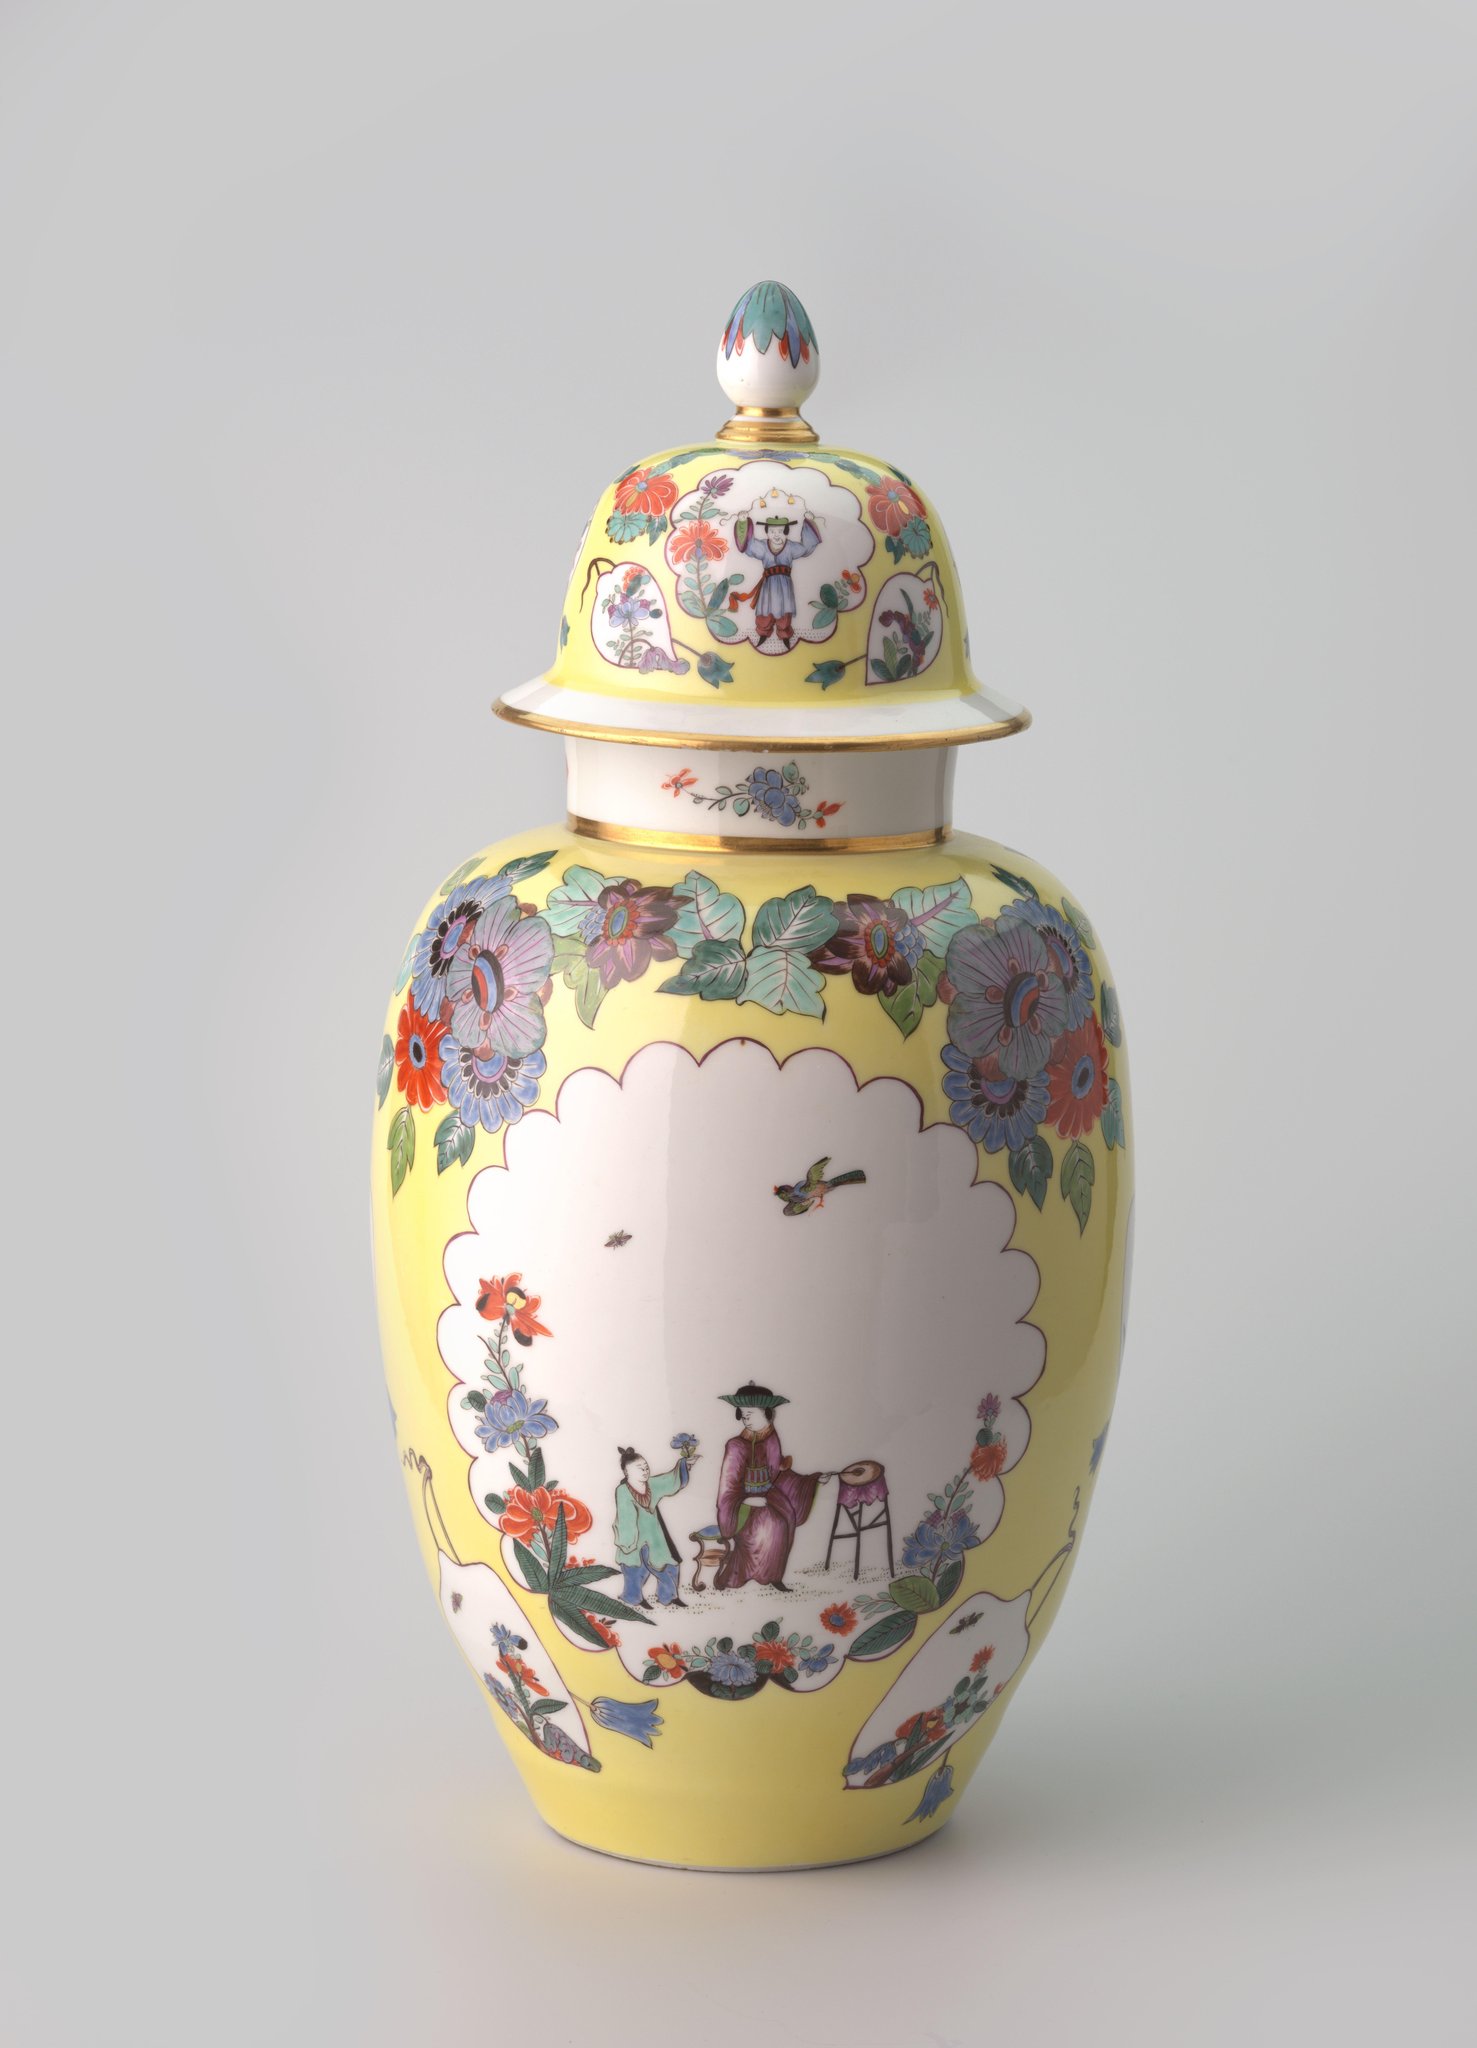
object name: decoratief object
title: Vaas met deksel, veelkleurig beschilderd met Chinezen in uitgespaarde gelobde cirkels in een gele fond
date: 1735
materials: porcelain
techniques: painted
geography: meissen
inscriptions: number: ‘259.’, number: ‘259’, factory mark: ‘AR’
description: Two vases. Porcelain. Meissen, c. 1735.